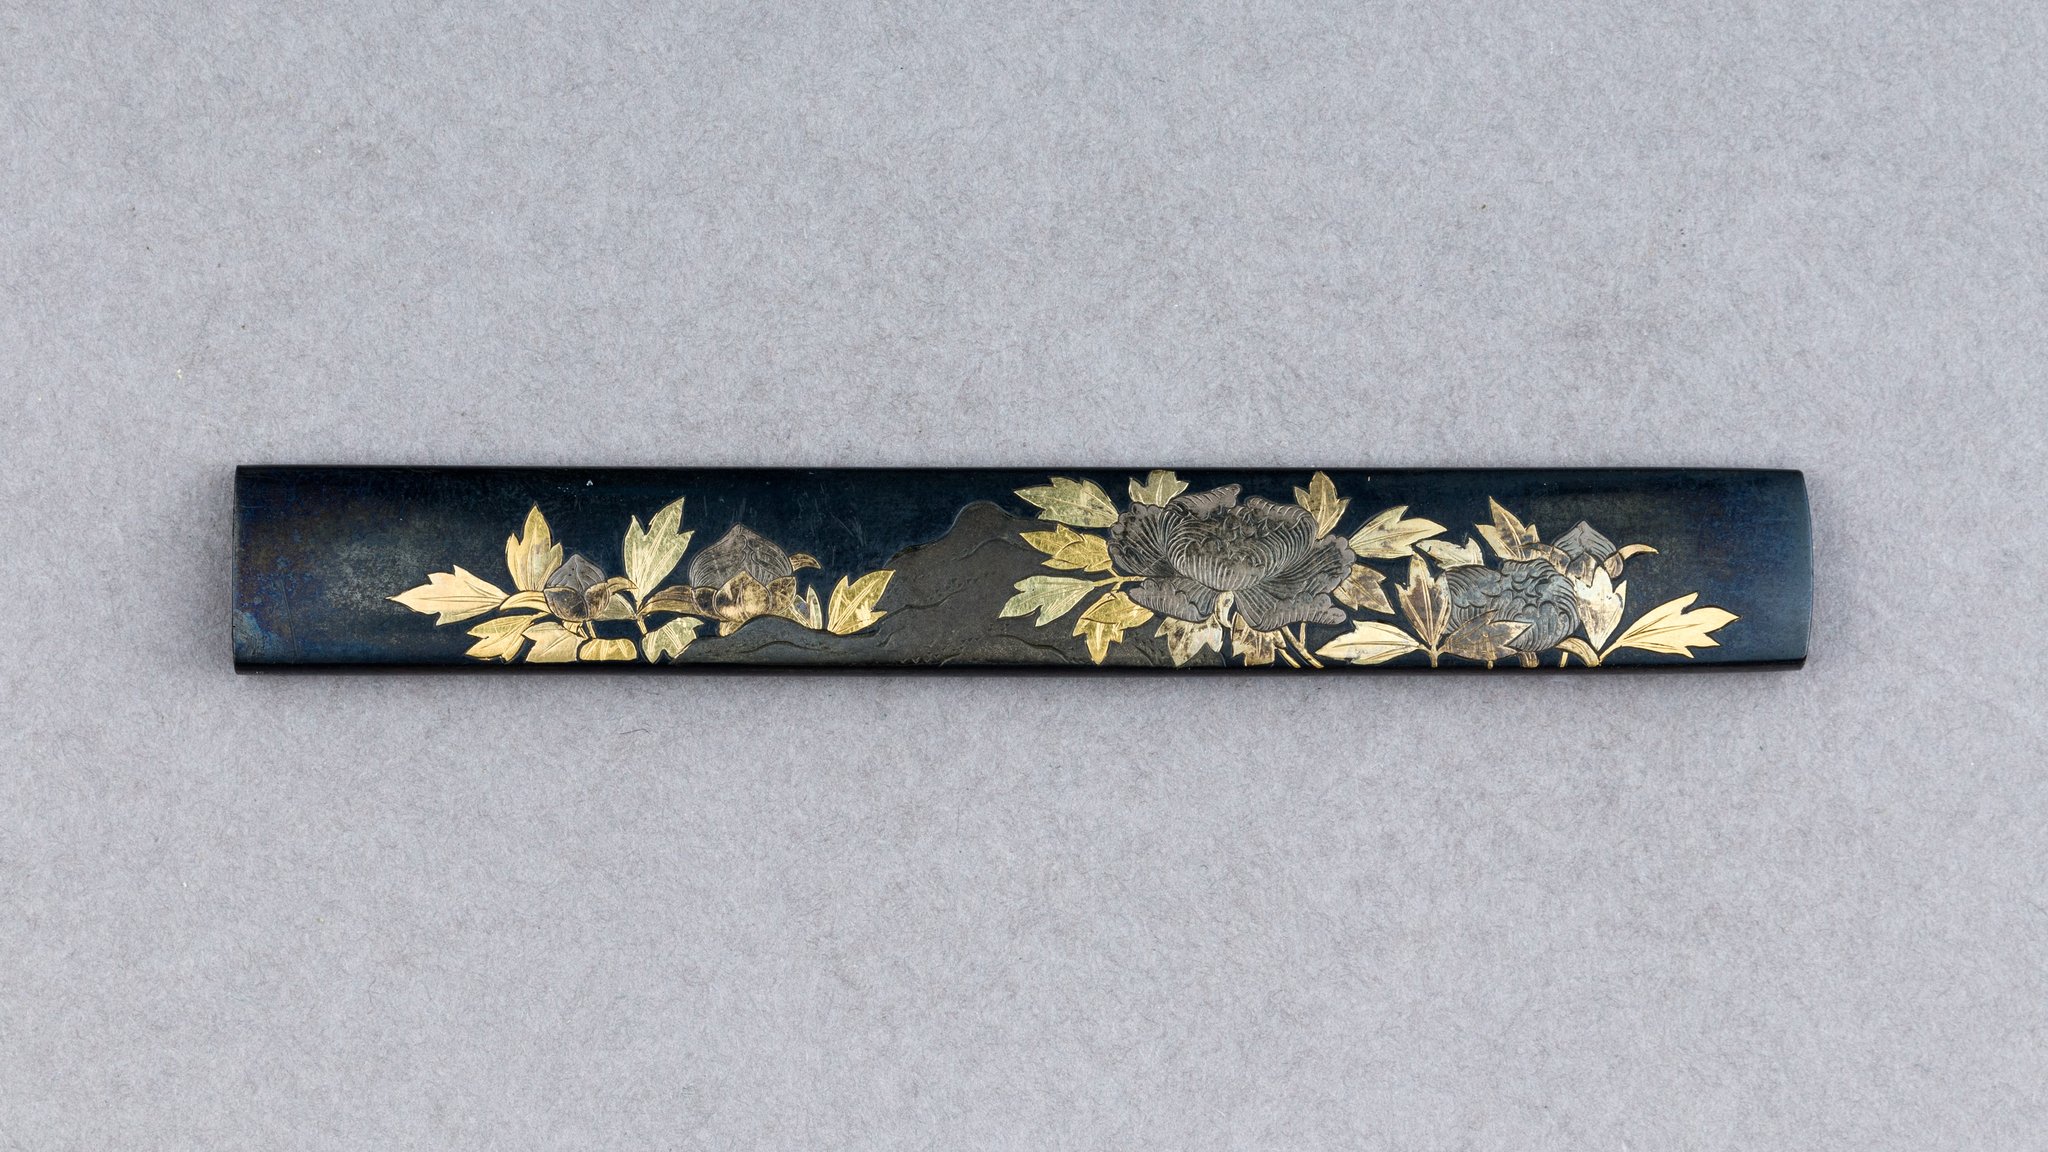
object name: knife handle kozuka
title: Knife Handle (Kozuka)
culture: japanese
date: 1615-1868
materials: gold alloy, silver alloy, gold, silver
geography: japan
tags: flowers